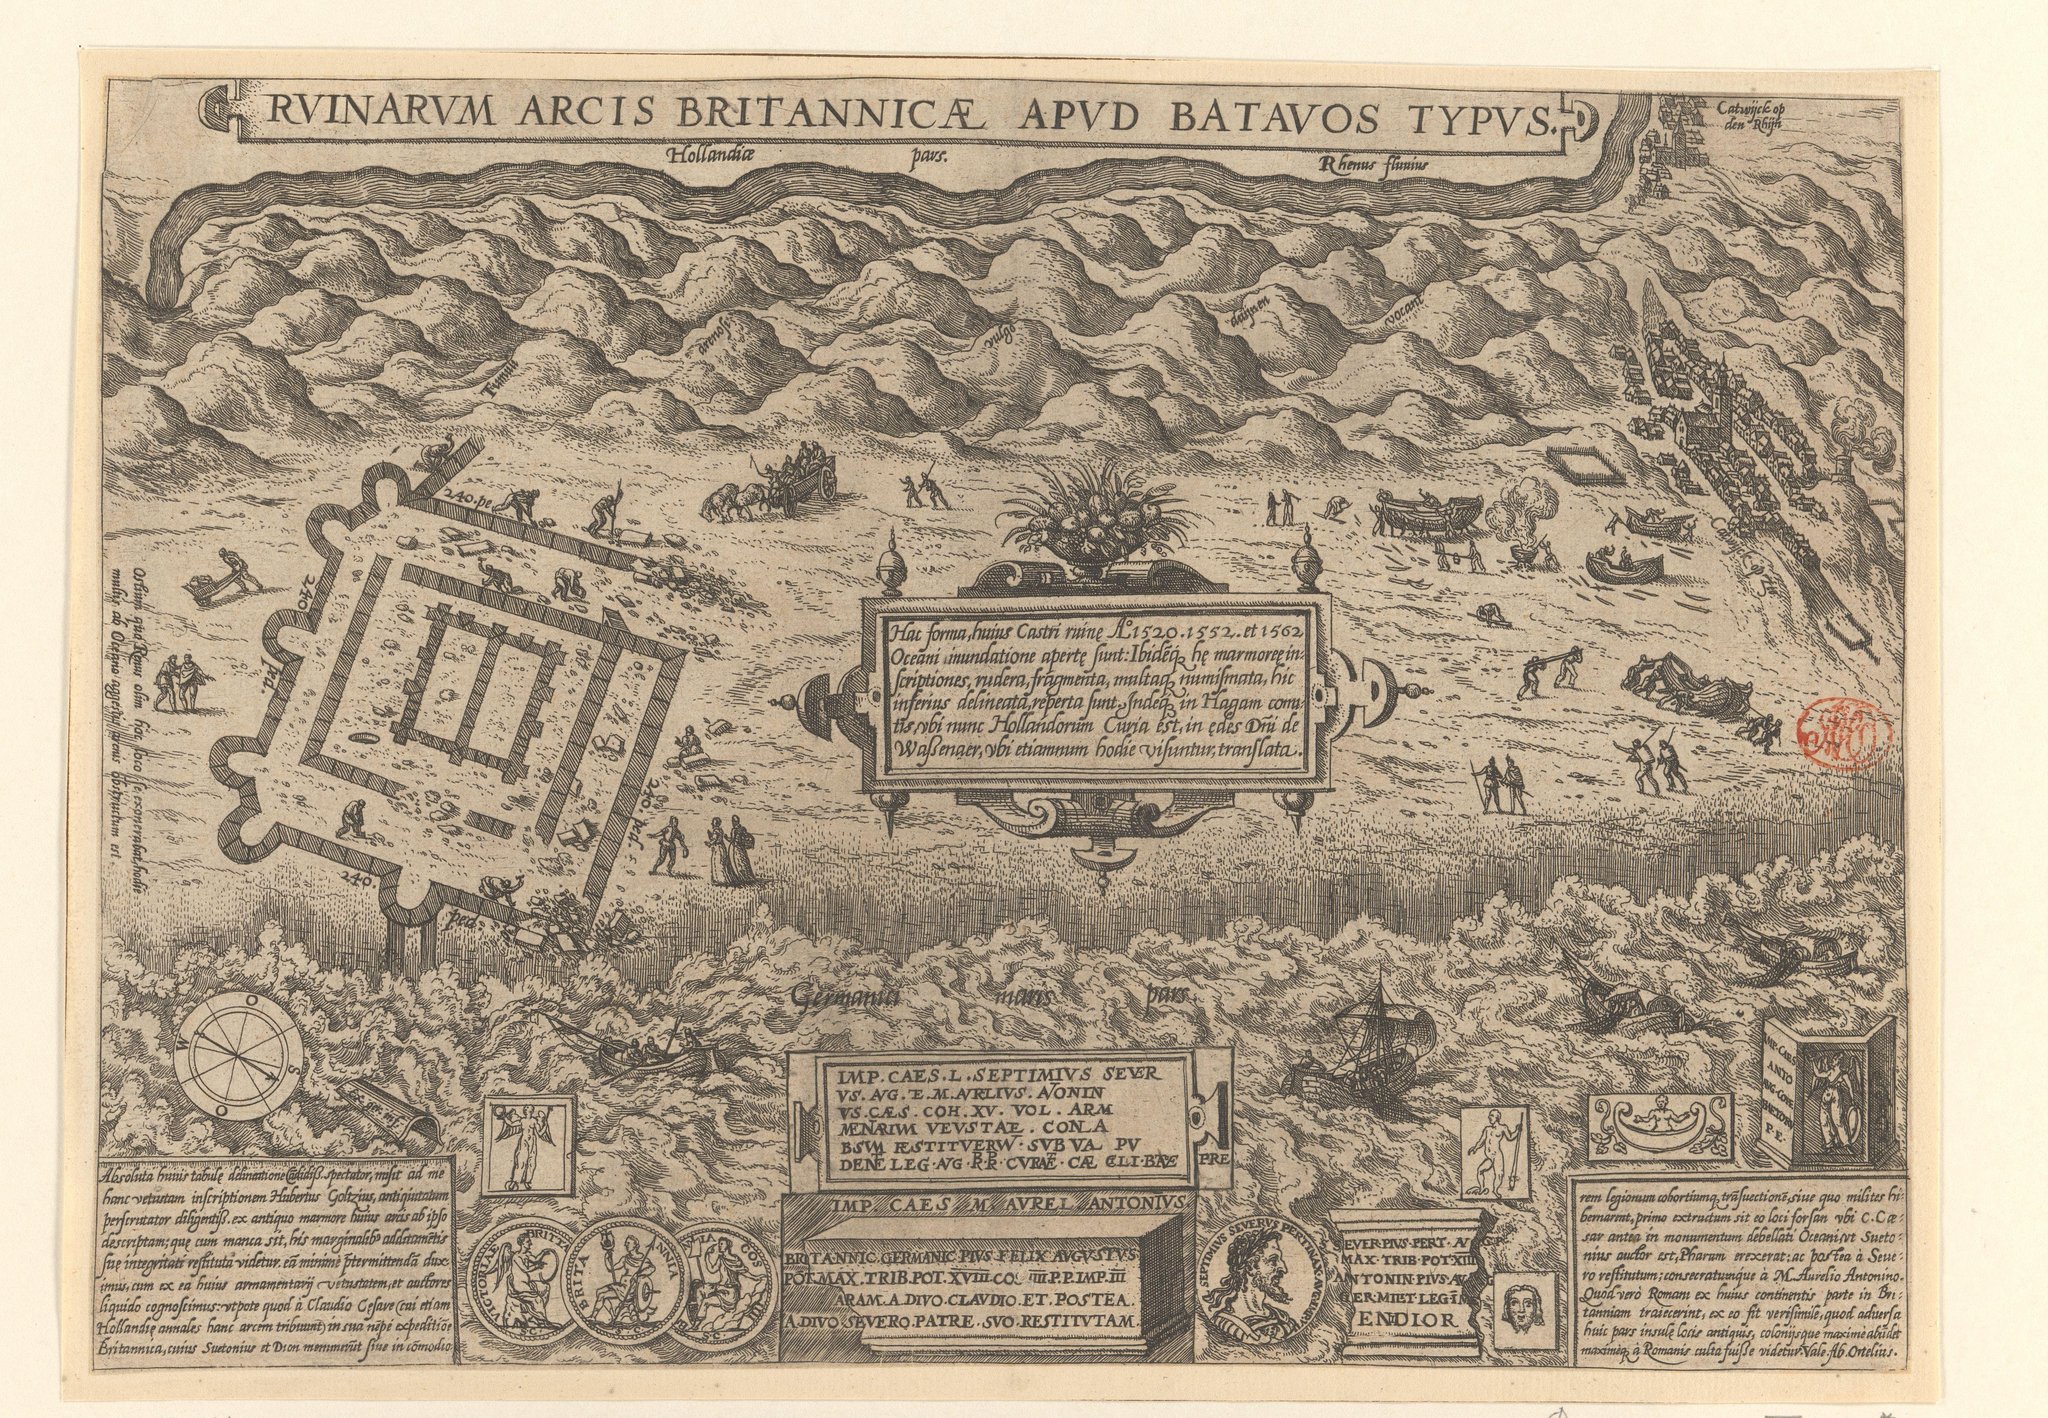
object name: print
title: De Brittenburg bij Katwijk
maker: Anonymous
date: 1579-1581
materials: paper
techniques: etching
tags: landscape with ruins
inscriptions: collector's mark: Lugt 195, collector's mark: Lugt 2228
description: Kustlandschap met plattegrond van de fundamenten van het Huis te Britten. Onderaan cartouches met teksten in het Latijn, enkele munten en andere vondsten.